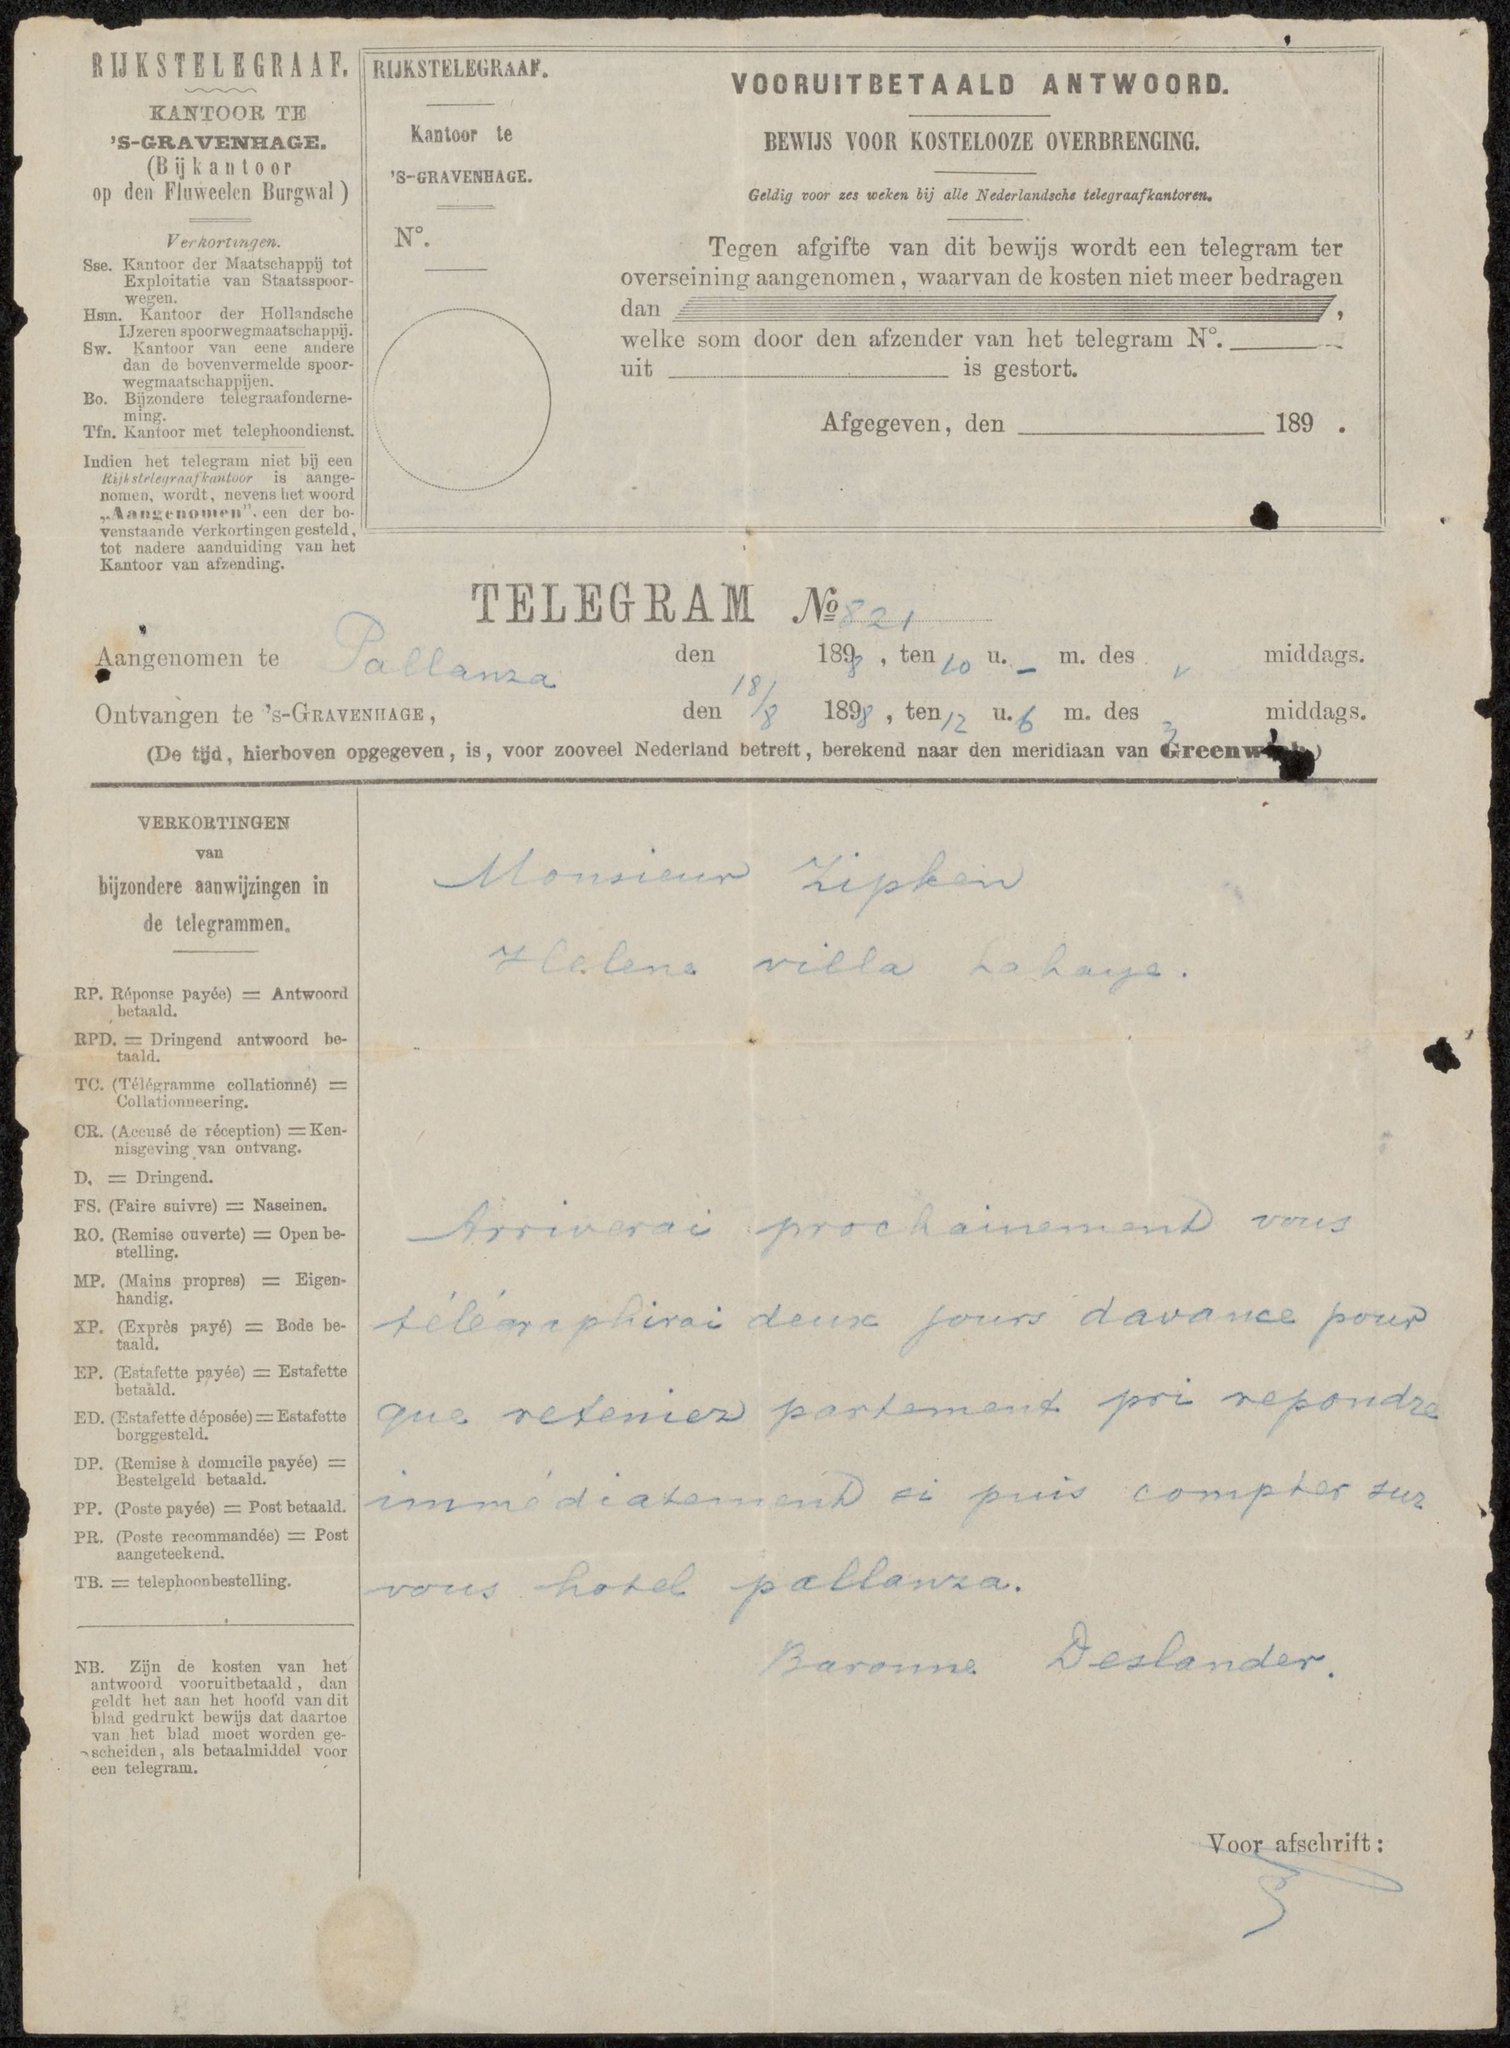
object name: telegram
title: Telegram aan Philip Zilcken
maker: baronne madeleine deslandes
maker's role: schrijver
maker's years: 1866-1929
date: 1898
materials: paper, pencil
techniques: printing, writing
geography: pallanza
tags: the hague, painter, draughtsman, philip zilcken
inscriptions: collector's mark: ‘RPK’